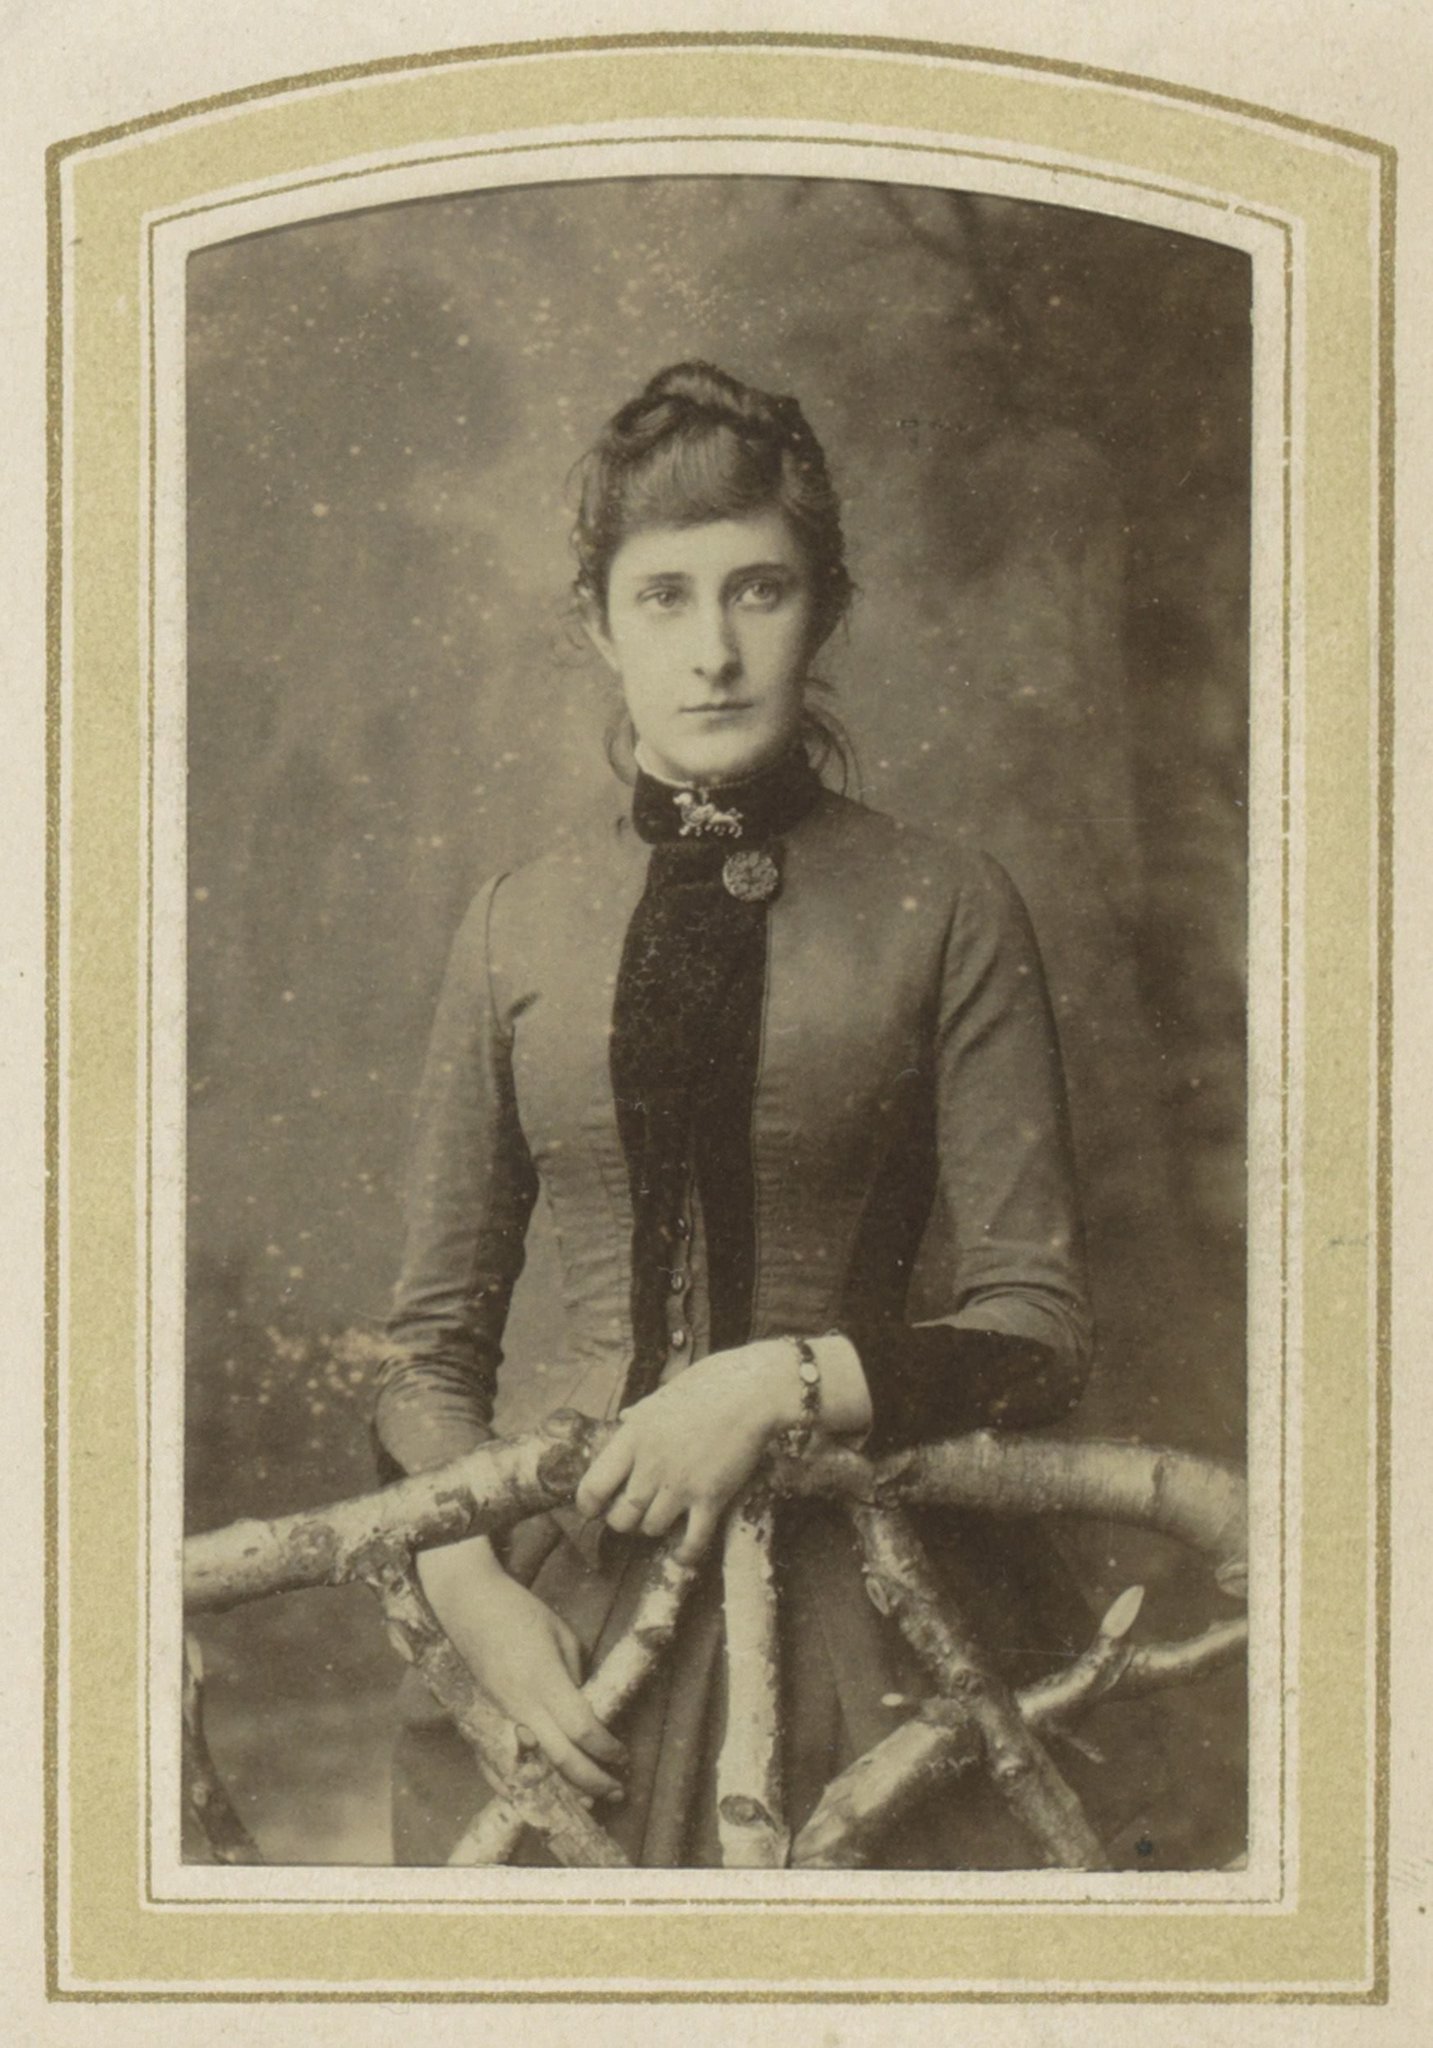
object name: carte de visite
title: Portret van een vrouw in een jurk bij een hek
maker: johan herman van der laag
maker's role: fotograaf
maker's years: 1865-1937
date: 1895-1920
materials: cardboard, paper, photographic support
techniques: albumen print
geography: wageningen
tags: studio requisites ~ photographer, historical persons, ornaments, jewels, brooch, agraffe, clasp, dress, gown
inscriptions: address: ‘Wageningen’, address: ‘Wageningen naast het station’, name: ‘J.H. van der Laag voorheen W. Oldenkamp’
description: Onderdeel van Fotoalbum van een Nederlandse familie met 168 cartes-de-visite en kabinetfoto's.